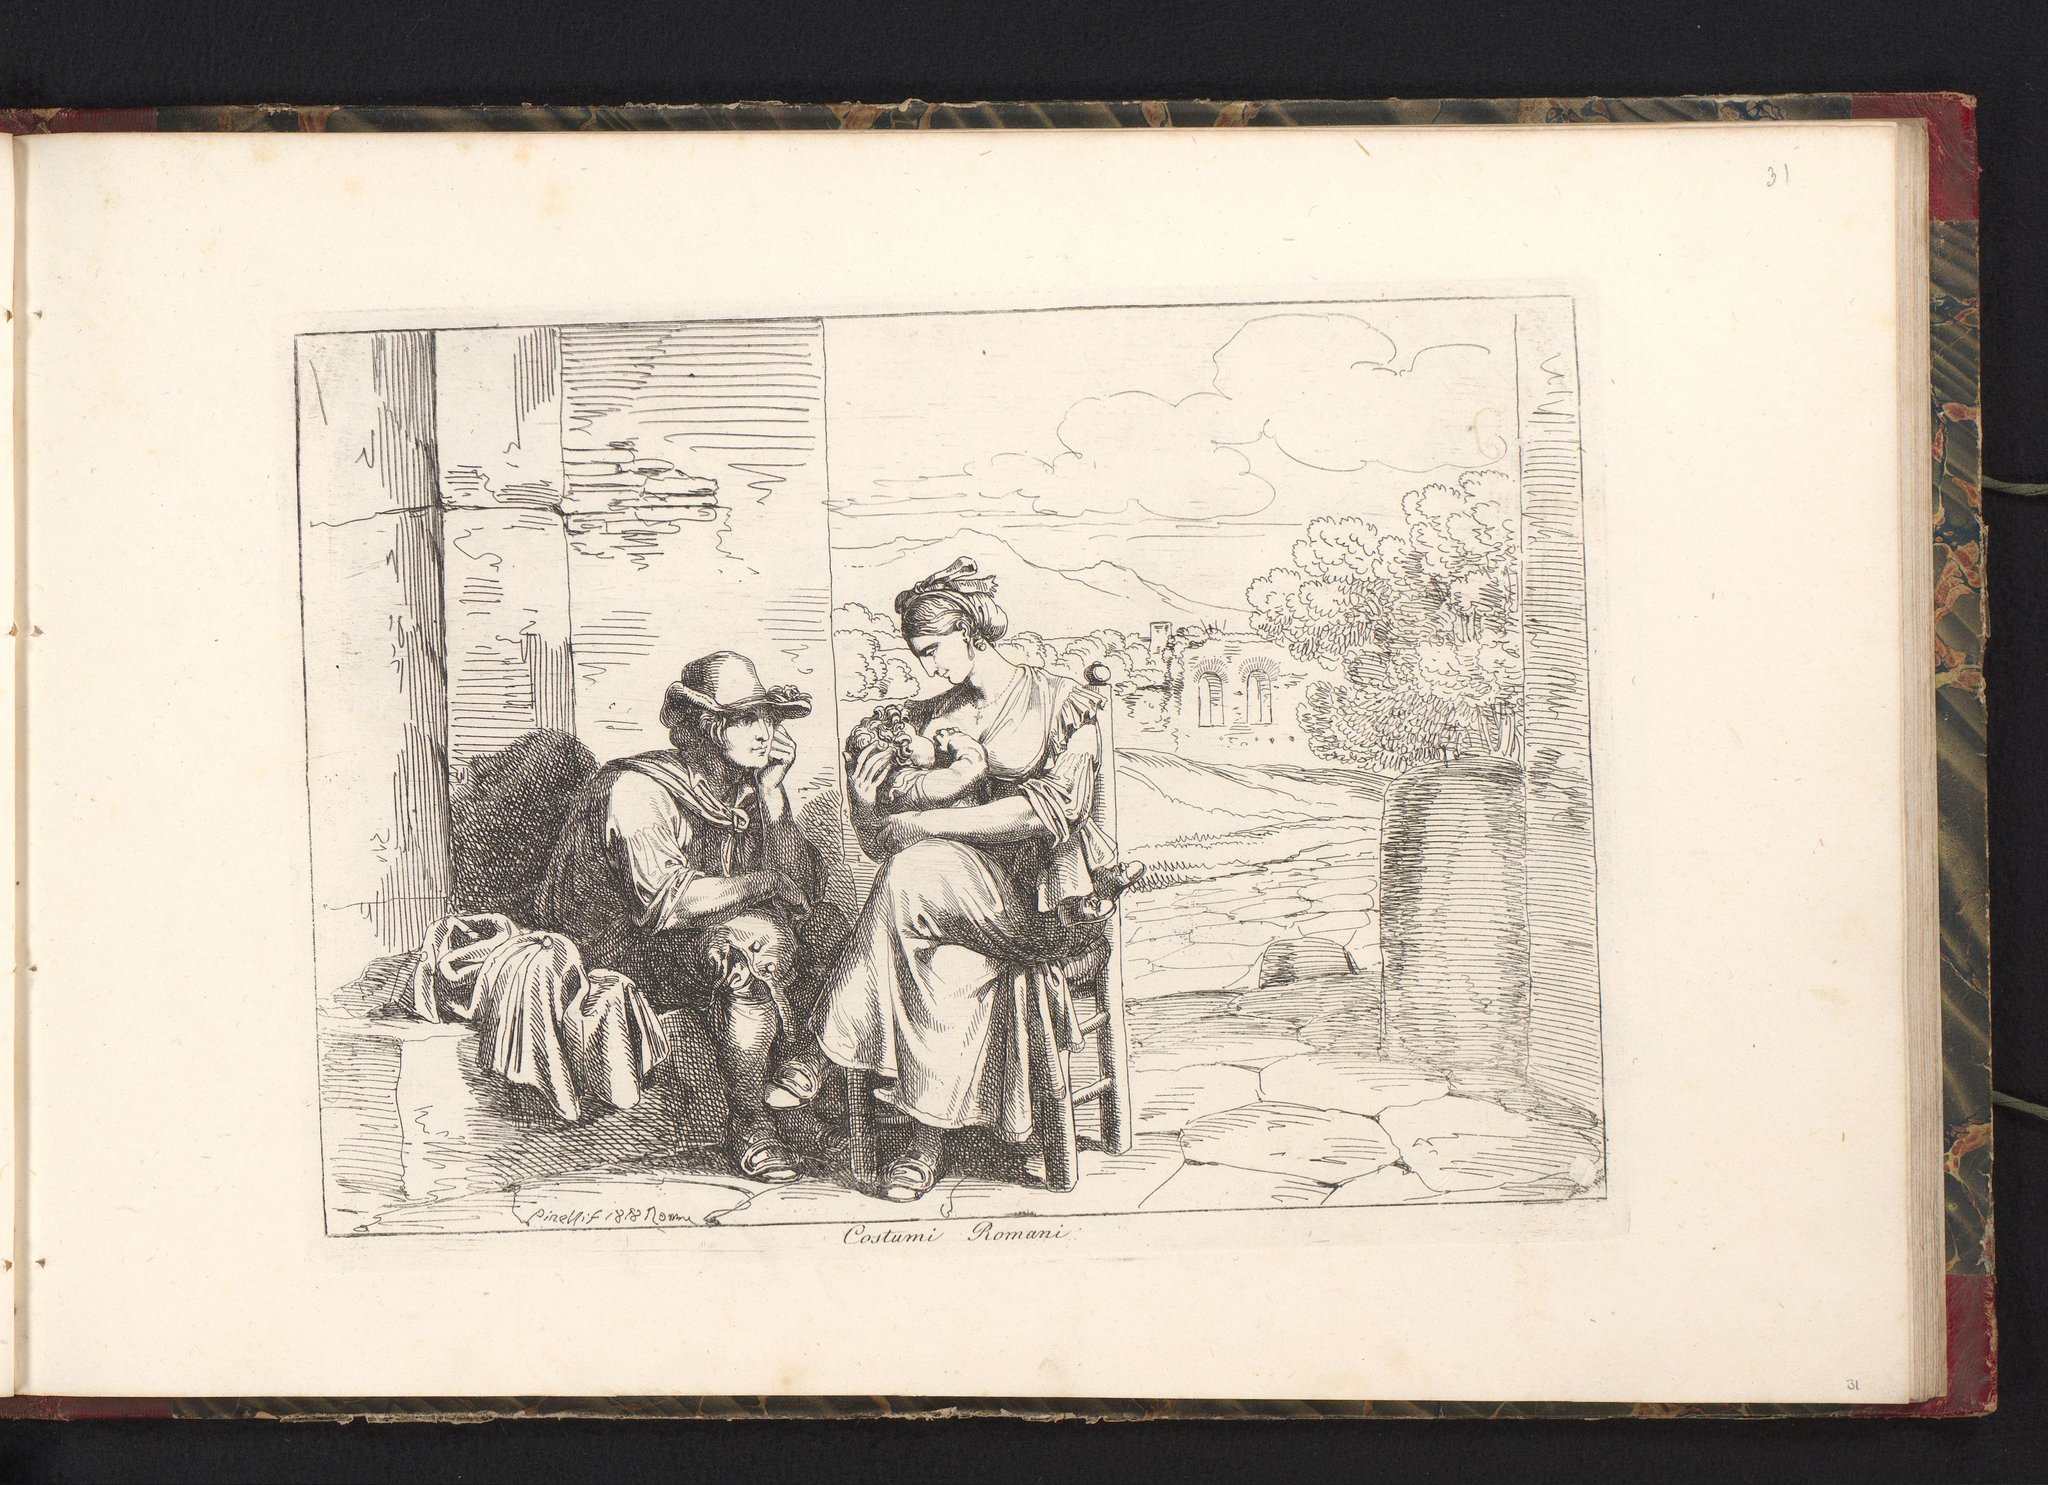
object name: album leaf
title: Gezin uit Rome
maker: bartolomeo pinelli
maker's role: draughtsman, print maker, sculptor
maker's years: 1781-1835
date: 1818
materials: paper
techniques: etching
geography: rome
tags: landscape with ruins, feeding a baby, folk costume, regional costume, rome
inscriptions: date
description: Een zittende jongeman kijkt naar een jonge vrouw die een kind de borst geeft. Op de achtergrond een landschap met ruïnes. De prent maakt deel uit van een album.